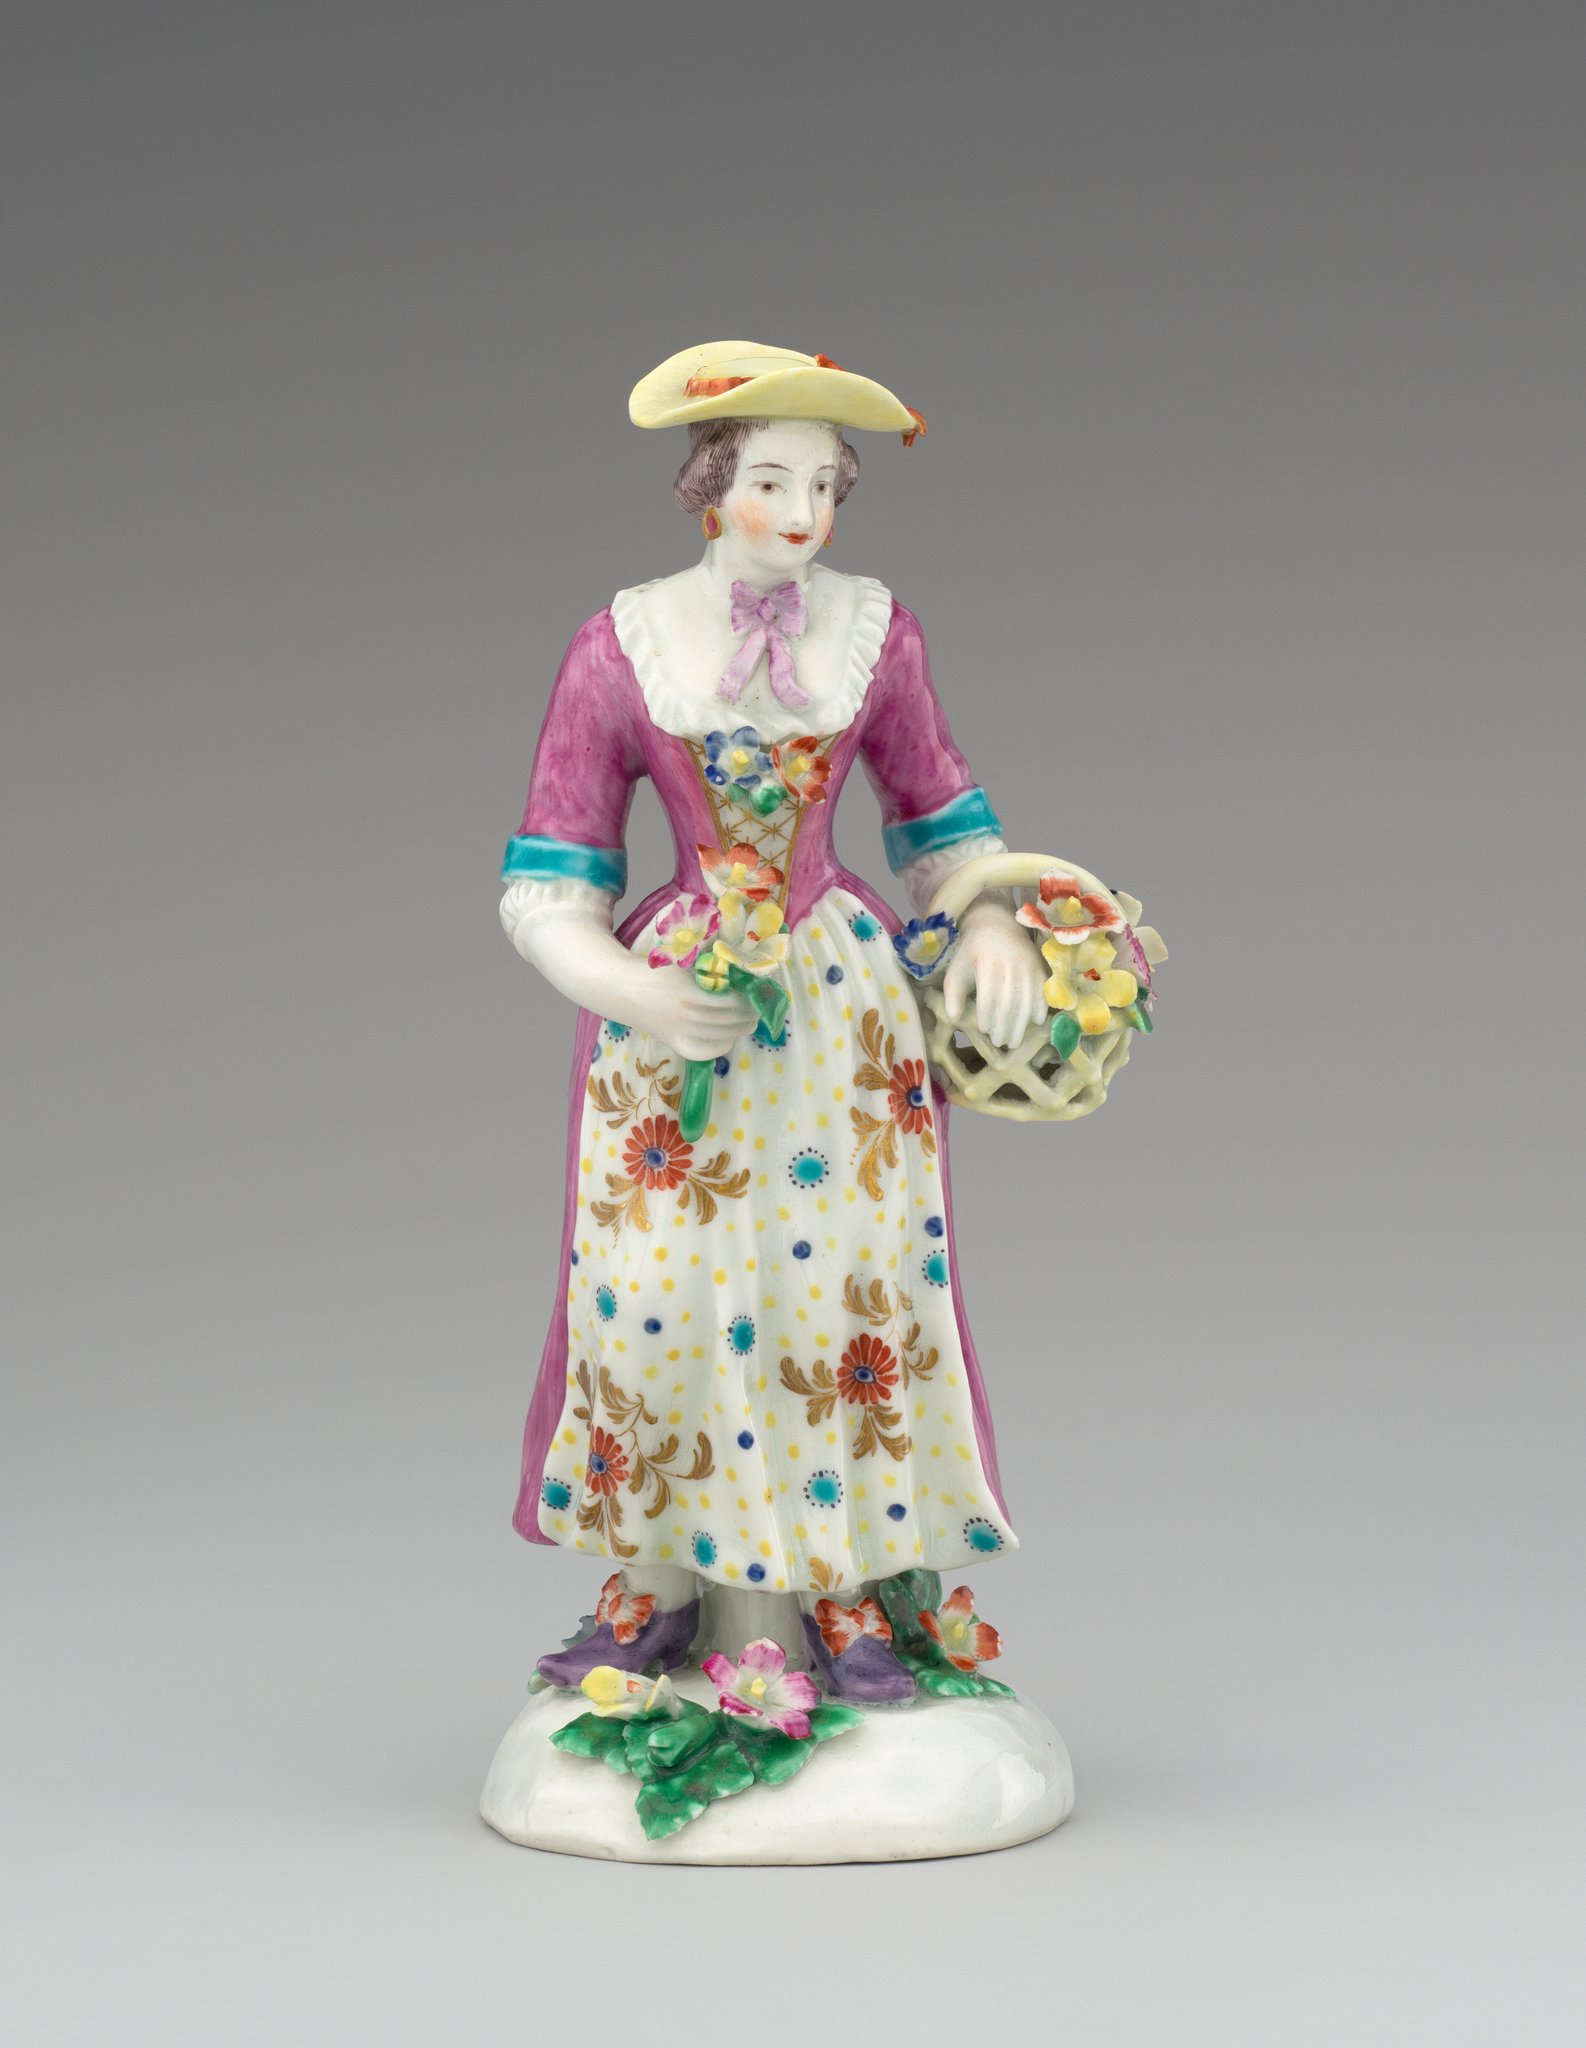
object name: figure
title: Companion (one of a pair)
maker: worcester factory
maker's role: factory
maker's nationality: british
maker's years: 1751-2008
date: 1770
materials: soft paste porcelain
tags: men,women